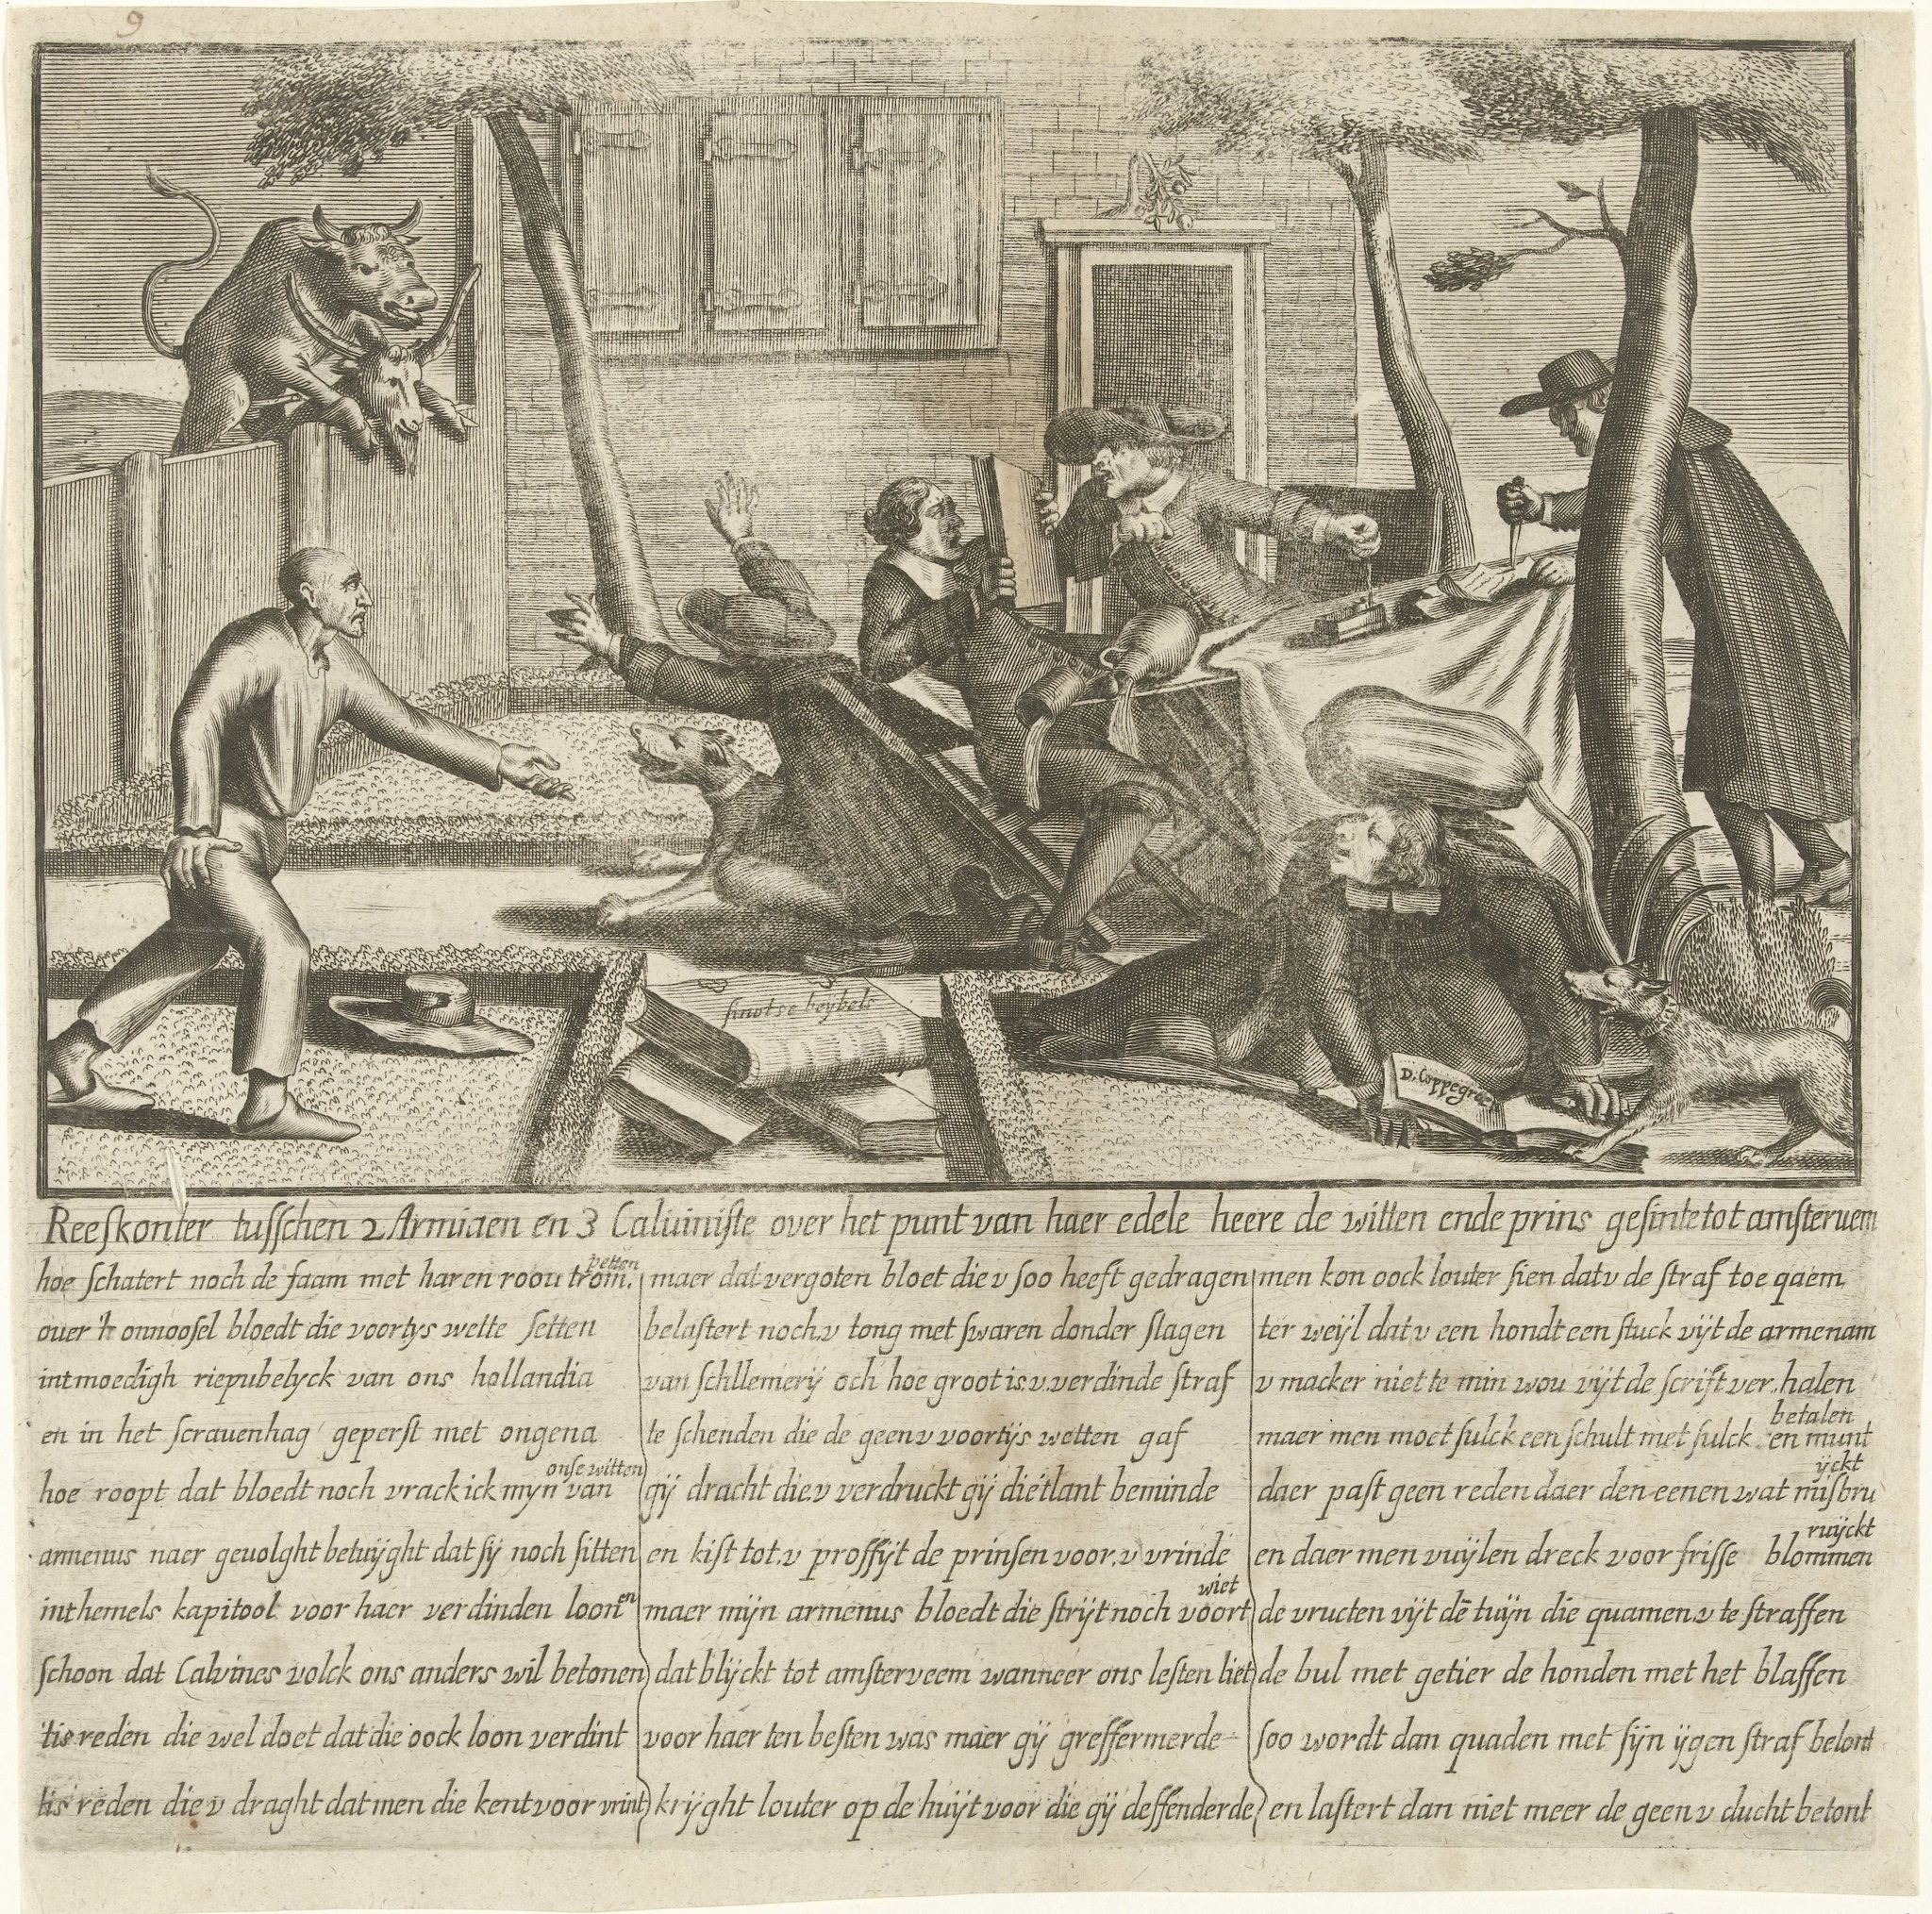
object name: cartoon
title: Reeskonter tusschen 2 Armiaen en 3 Calviniste over het punt van haer edele heere de witten ende prins gesinte tot amsterdem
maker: Anonymous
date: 1756-1759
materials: paper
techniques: engraving, etching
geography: northern netherlands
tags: dordrecht, cornelis de witt, the hague, politician, johan de witt, william iii (prince of orange and king of england, scotland, and ireland), animals (+ animals mating), quarrel, argument, fighting, amsterdam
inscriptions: collector's mark: Lugt 2228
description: Spotprent op de strijd tussen arminianen en calvinisten over de geboeders De Witt en de prinsgezinden te Amsterdam, waarschijnlijk ca. 1758. Arminianen en calvinisten gaan rond een tafel in een tuin met elkaar op de vuist, reden zijn de afwijkende meningen over de strijd tussen de gebroeders De Witt en de prins in 1672. Links wordt een toekijkende geit gedekt door een stier. Onder de prent een vers in 3 kolommen.